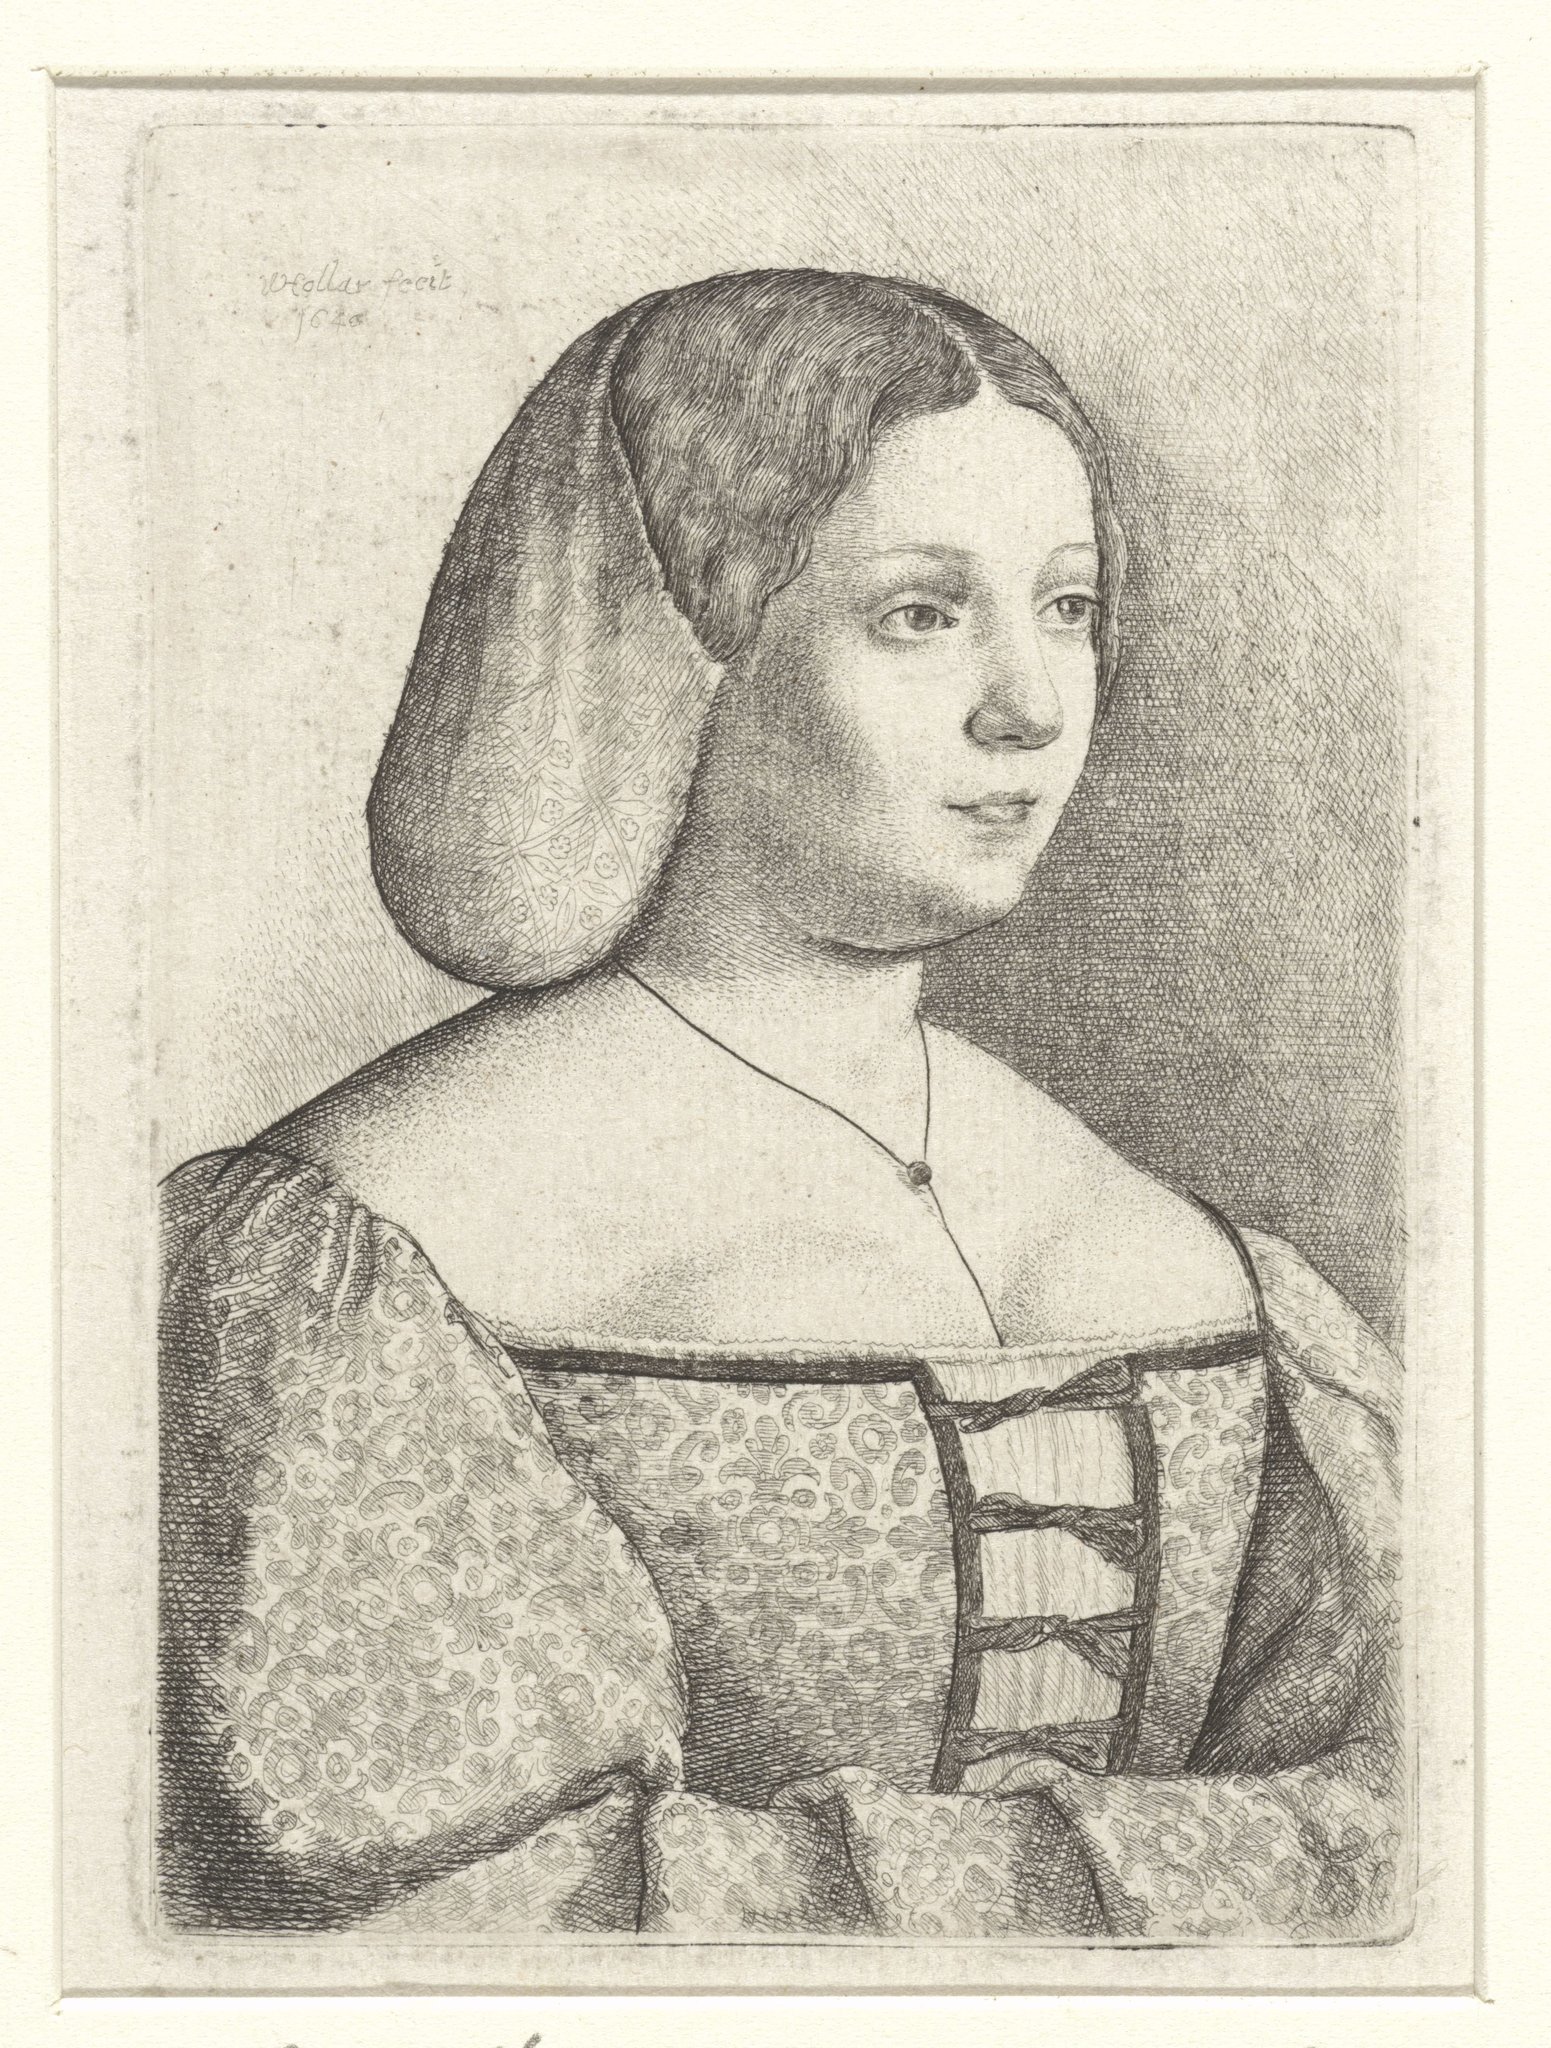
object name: print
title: Portret van een jonge vrouw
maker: wenceslaus hollar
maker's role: draughtsman, print maker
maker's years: 1607-1677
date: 1646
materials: paper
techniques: drypoint, etching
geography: antwerp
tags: anonymous historical person portrayed alone - bb - woman, styles of hairdress - aa - ~ women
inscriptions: collector's mark: Lugt 240